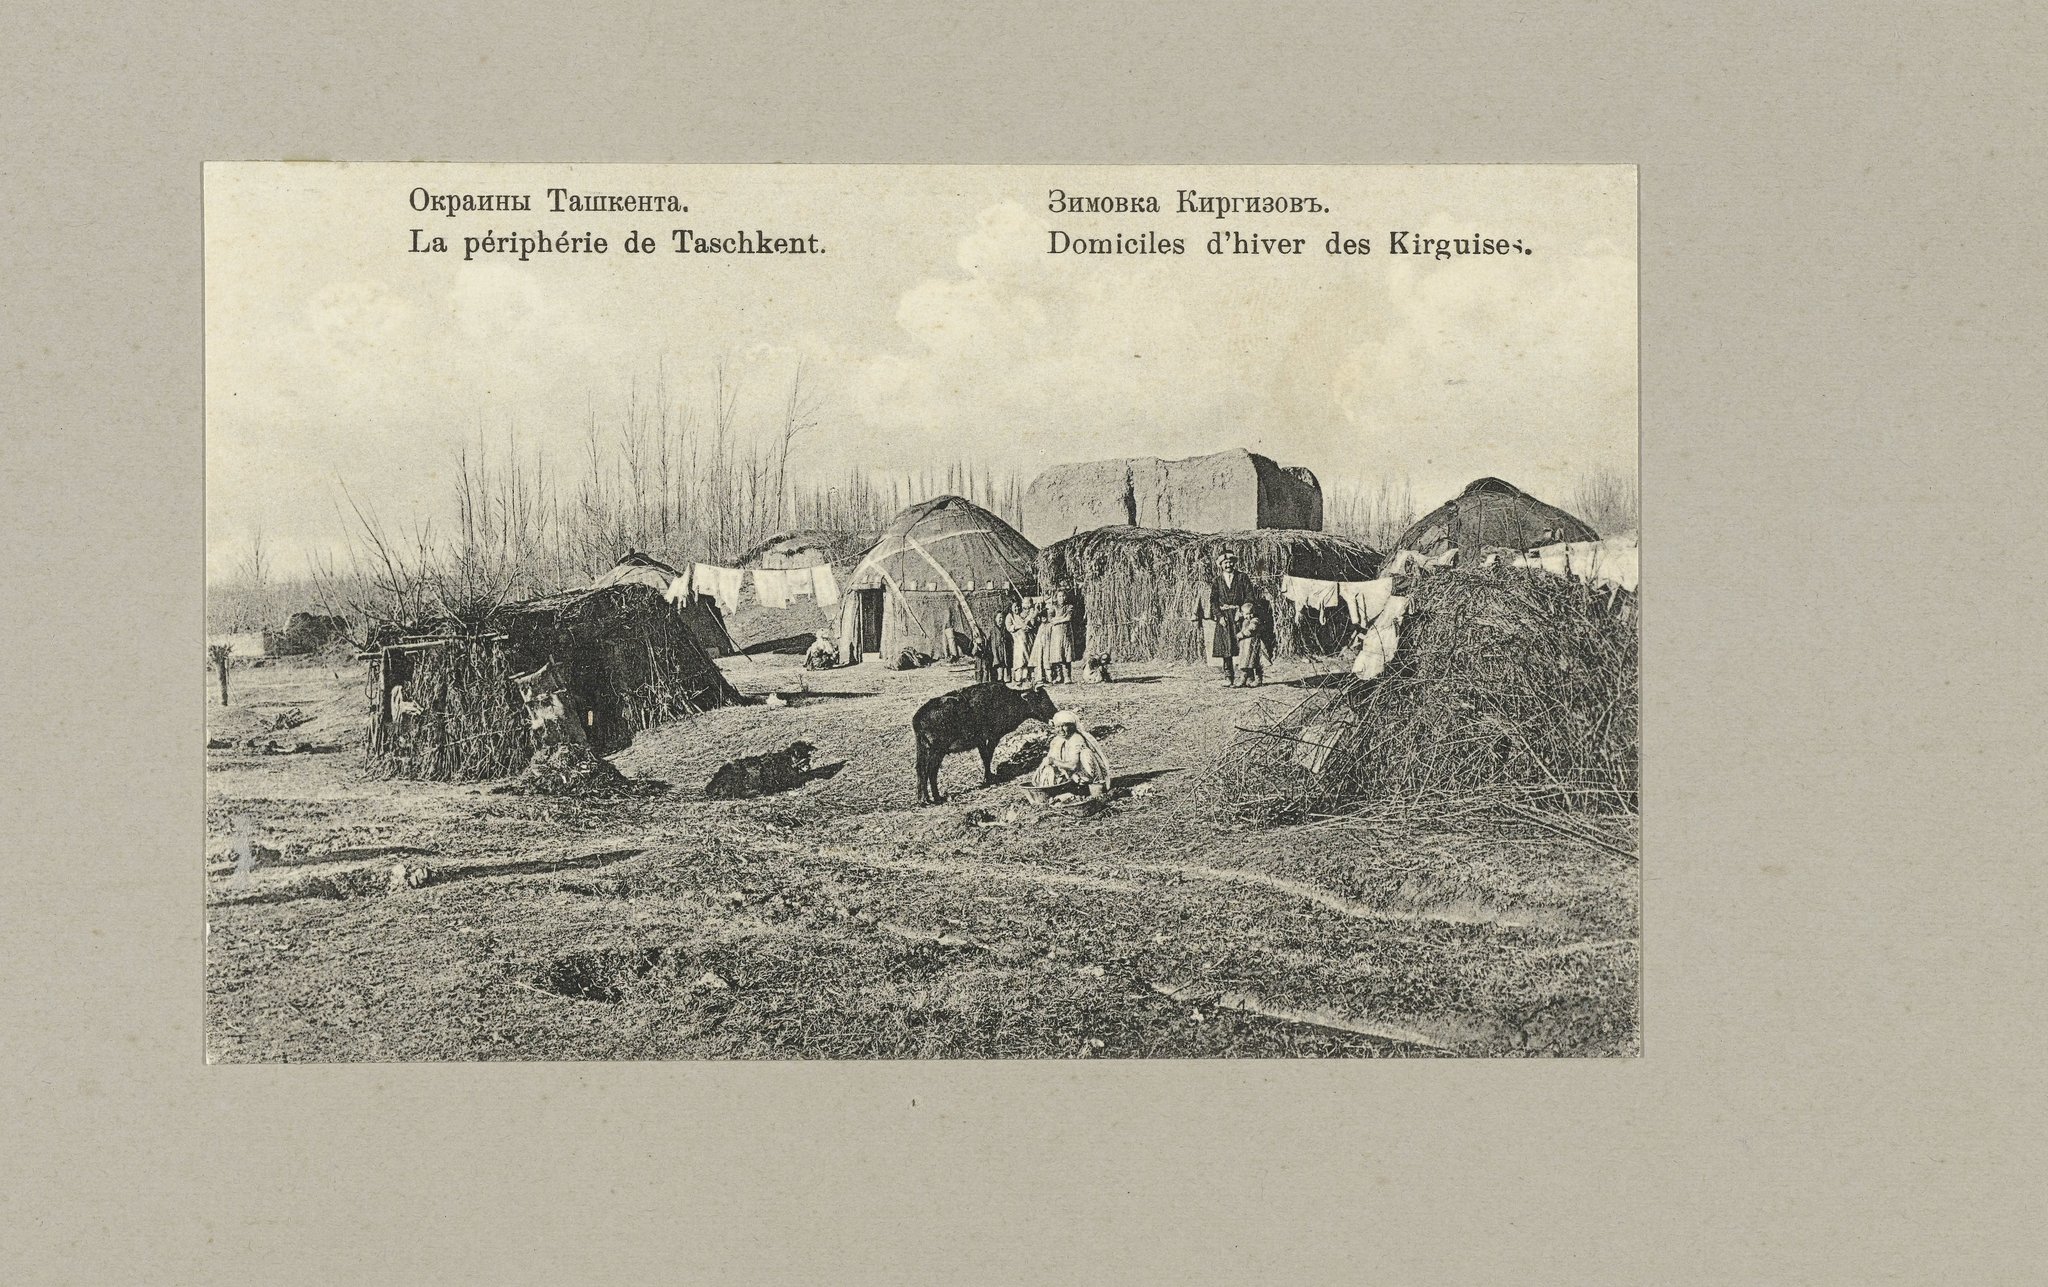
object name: photomechanical print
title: La périphérie de Taschkent. / Domiciles d'hiver des Kirguises.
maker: Anonymous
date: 1895-1915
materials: cardboard, paper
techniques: photograph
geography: tashkent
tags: tashkent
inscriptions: number: ‘1.’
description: Boven de titels in het Frans staan de titels in het Oezbeeks.